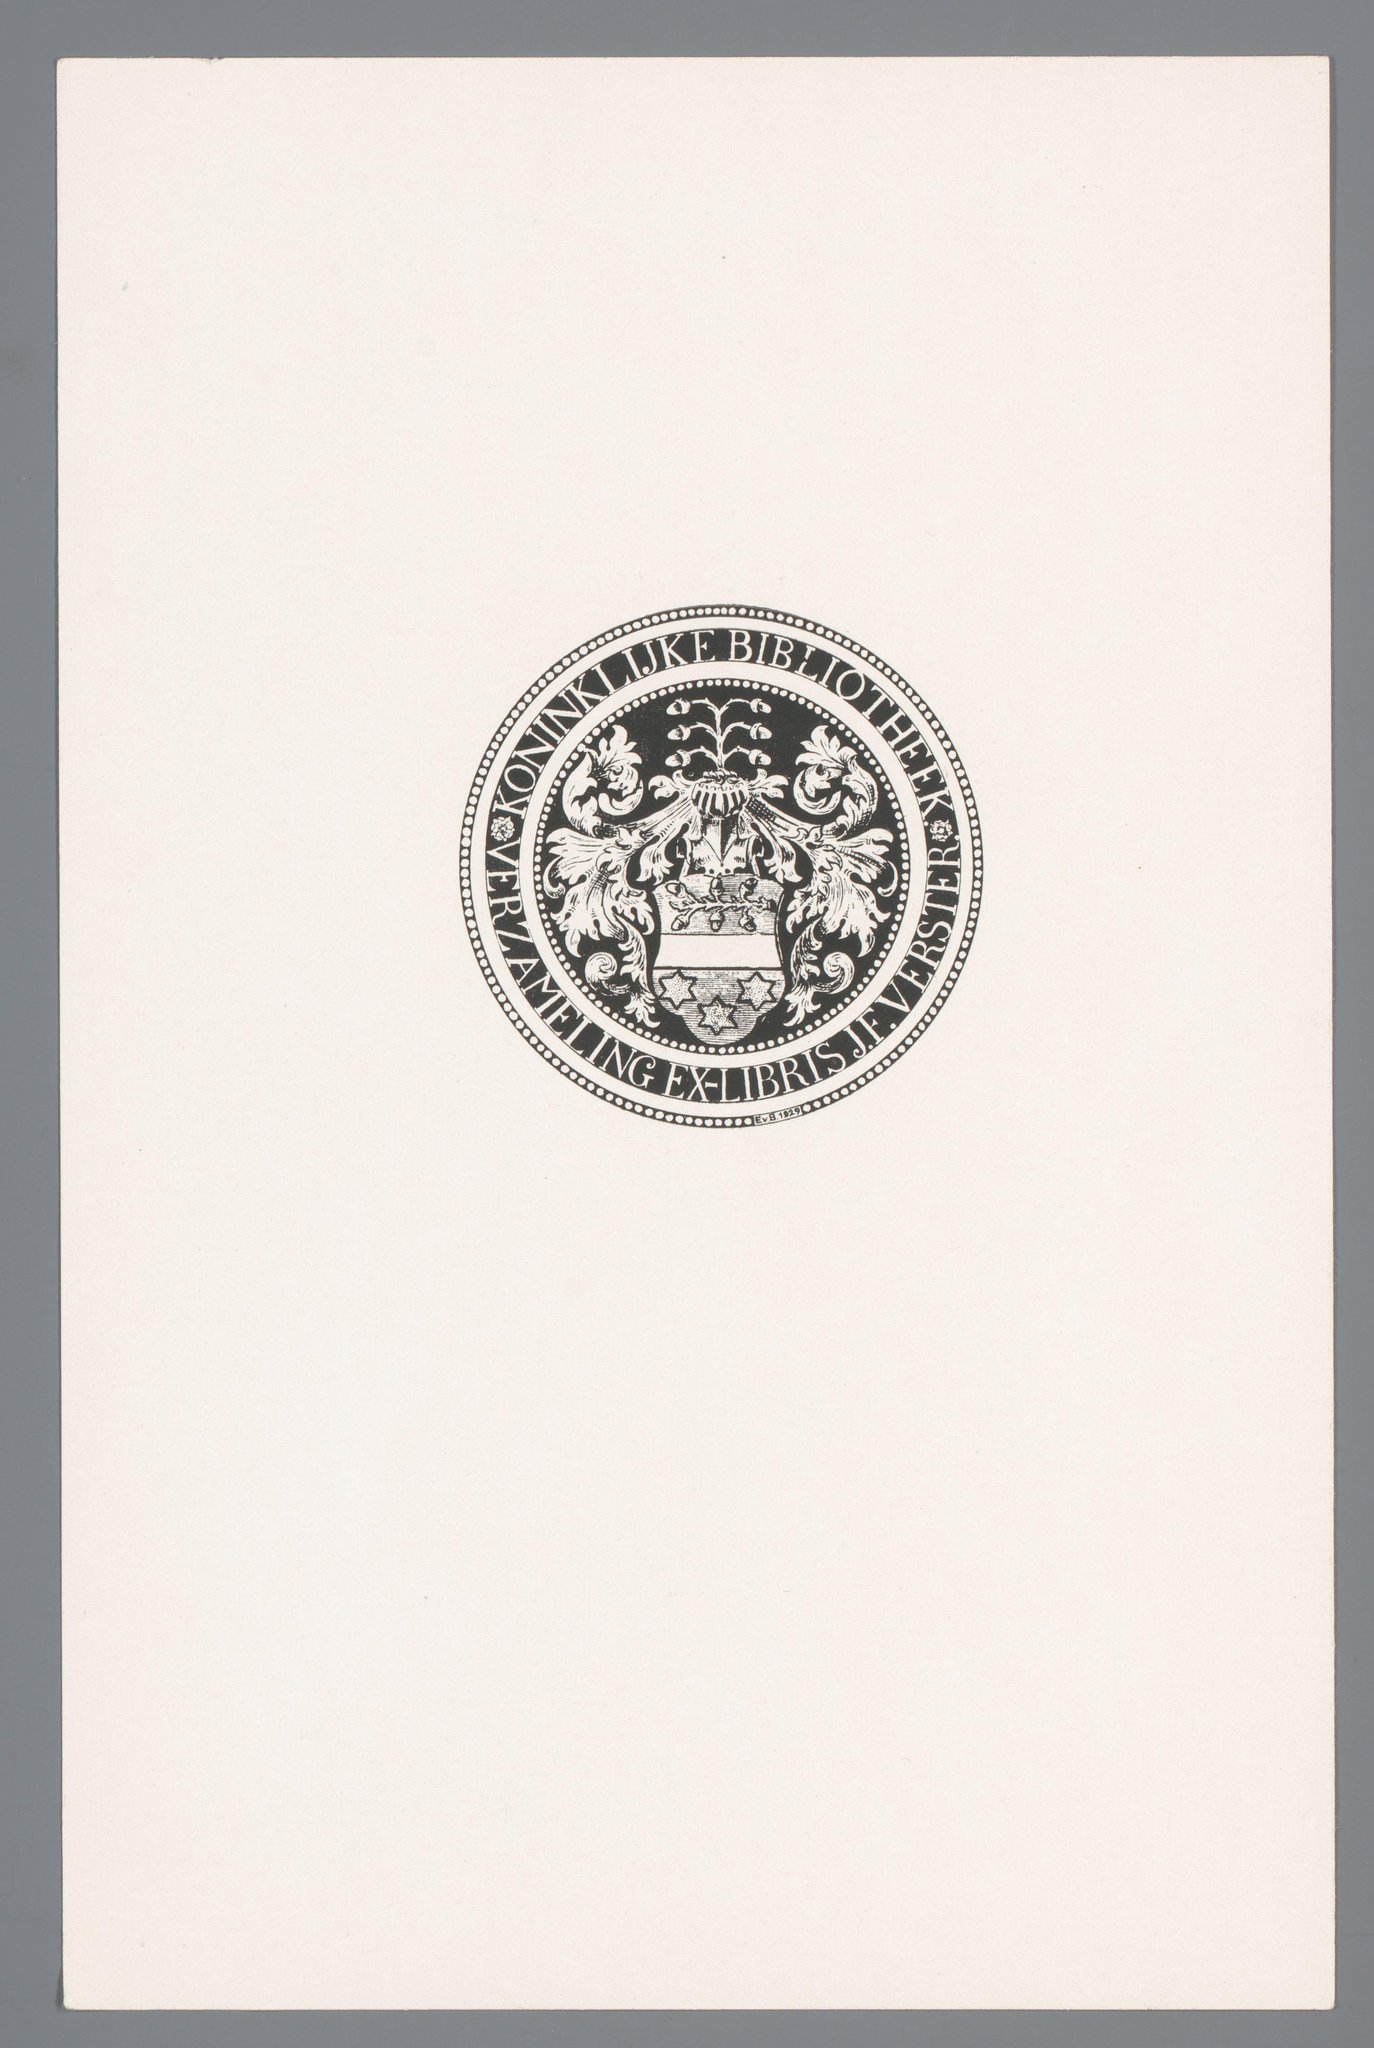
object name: bookplate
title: Ex libris van de Koninklijke Bibliotheek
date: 1929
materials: paper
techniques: printing block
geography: netherlands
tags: armorial bearing, heraldry, fruits: acorn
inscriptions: date